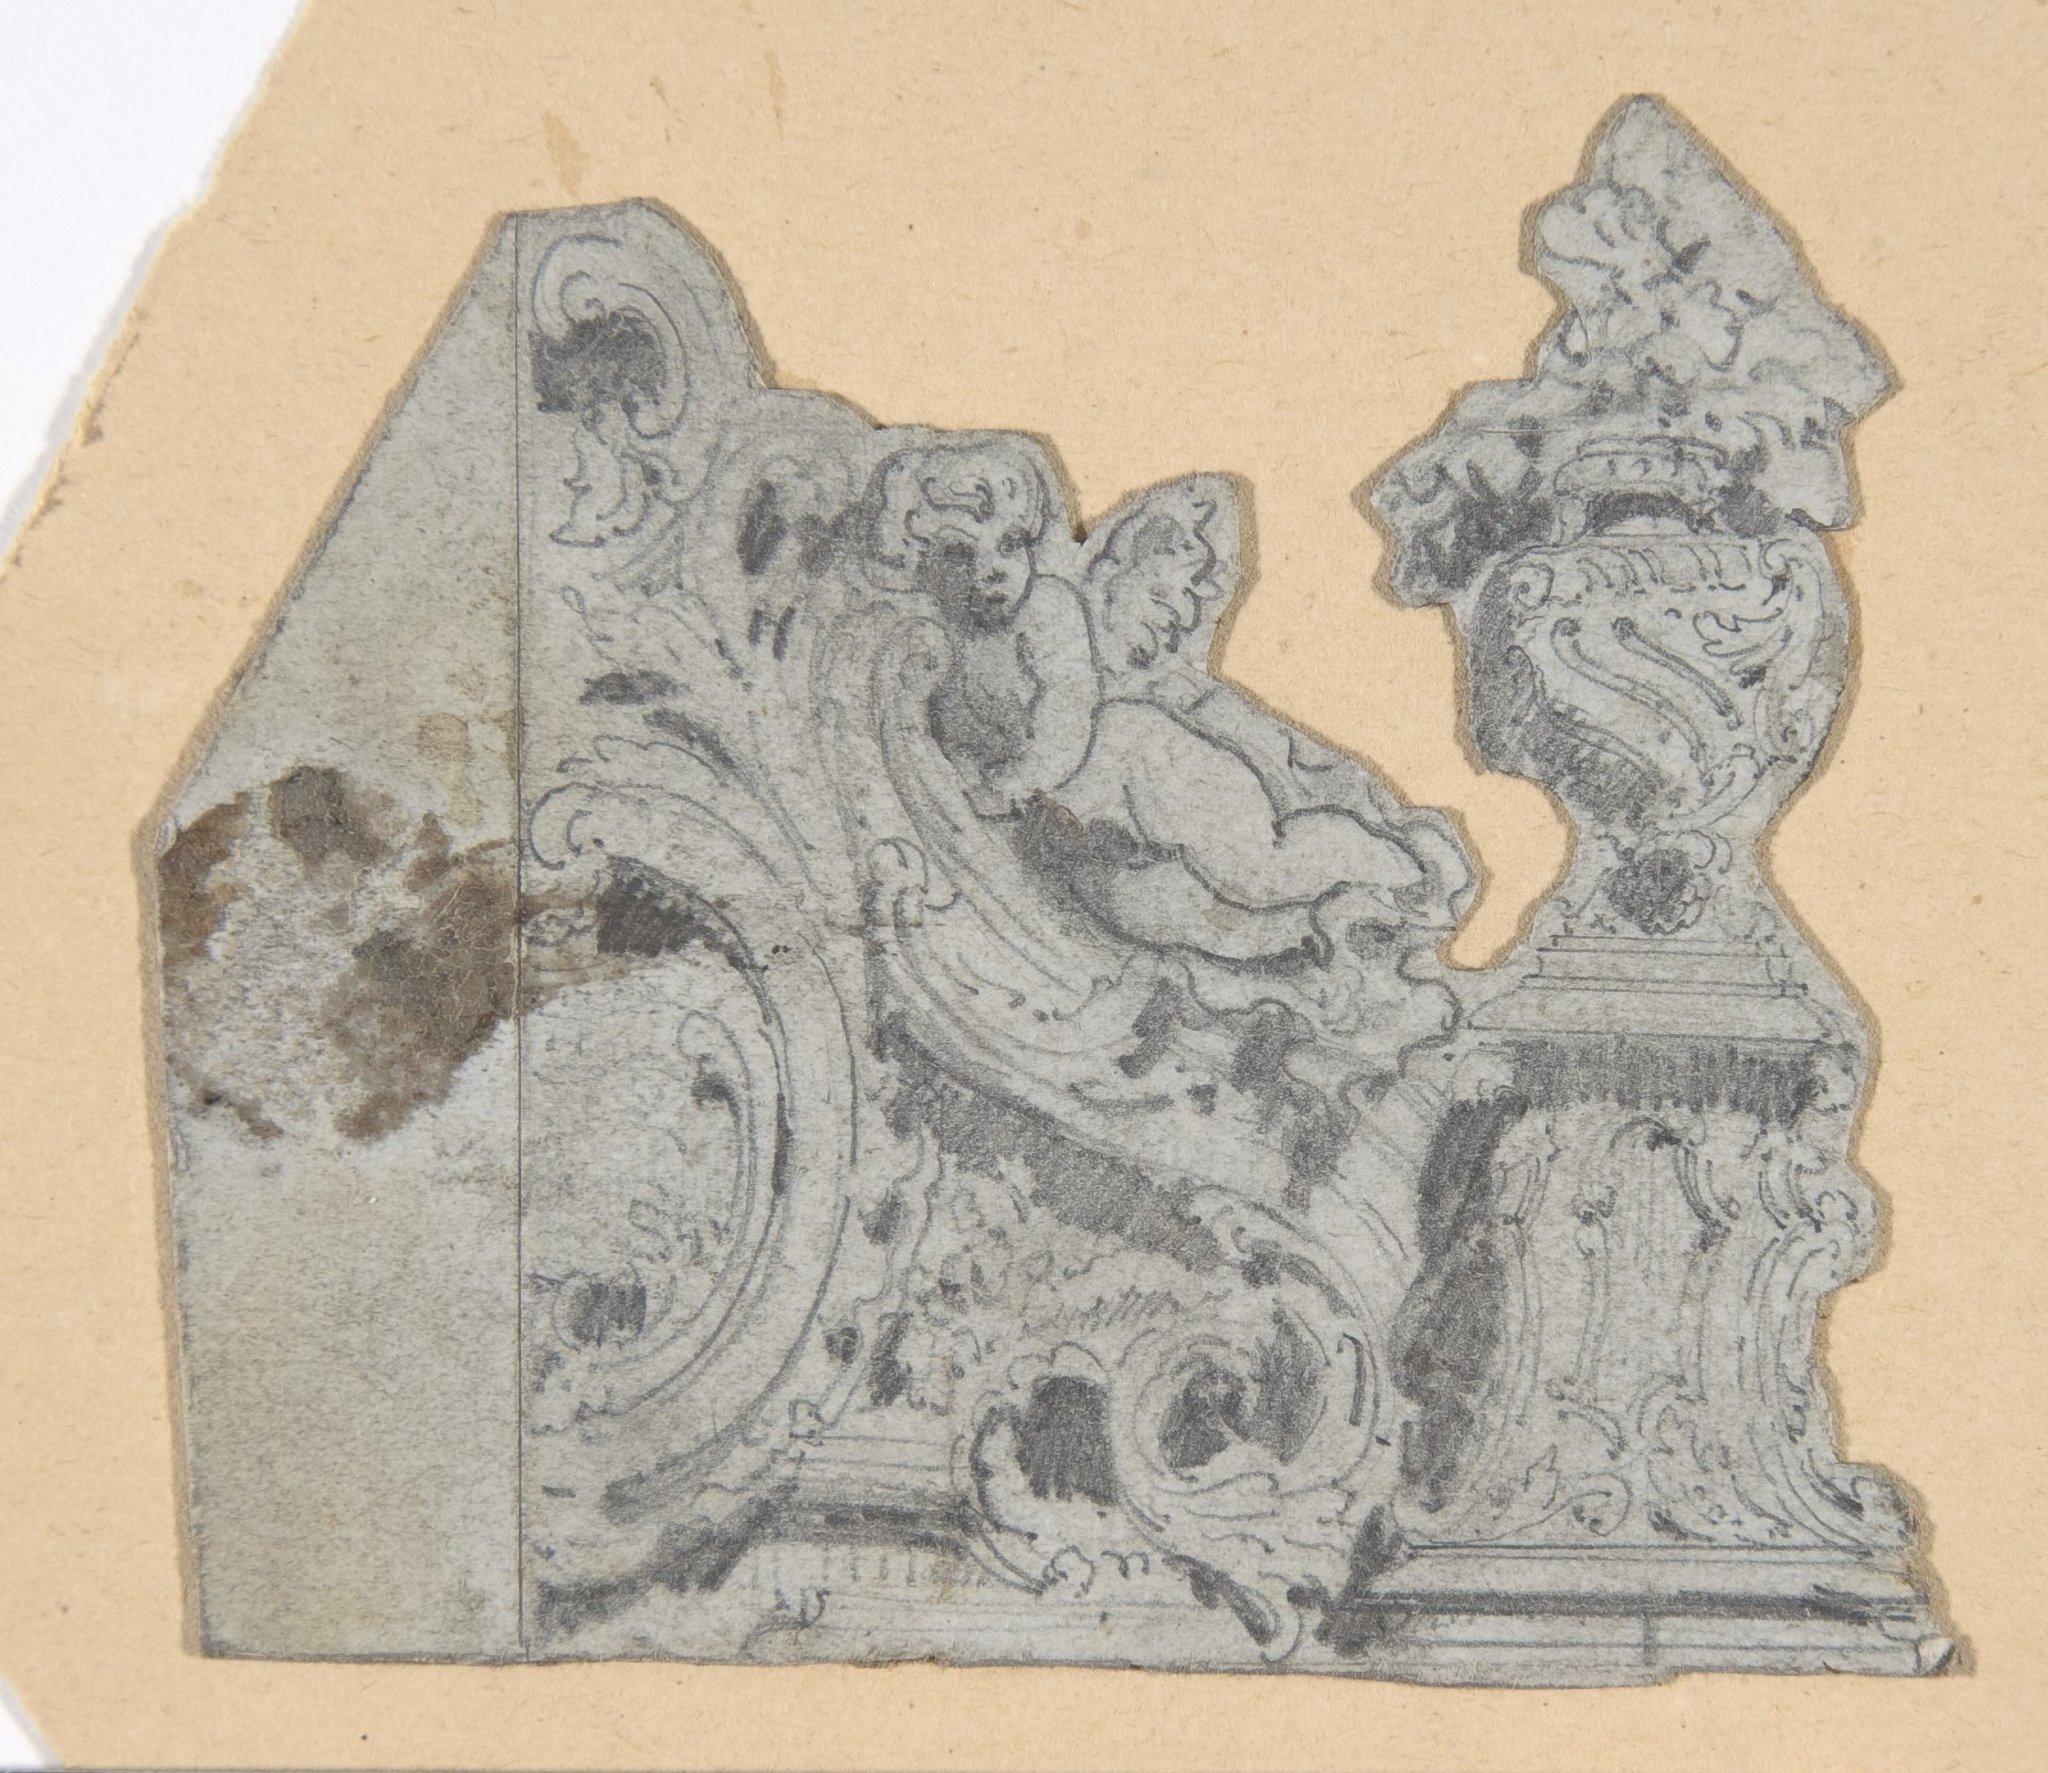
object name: drawing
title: Design for a Stage Set at the Opéra, Paris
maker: eugène cicéri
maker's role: artist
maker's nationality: french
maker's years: 1813-1890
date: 1830-1890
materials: graphite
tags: stage design